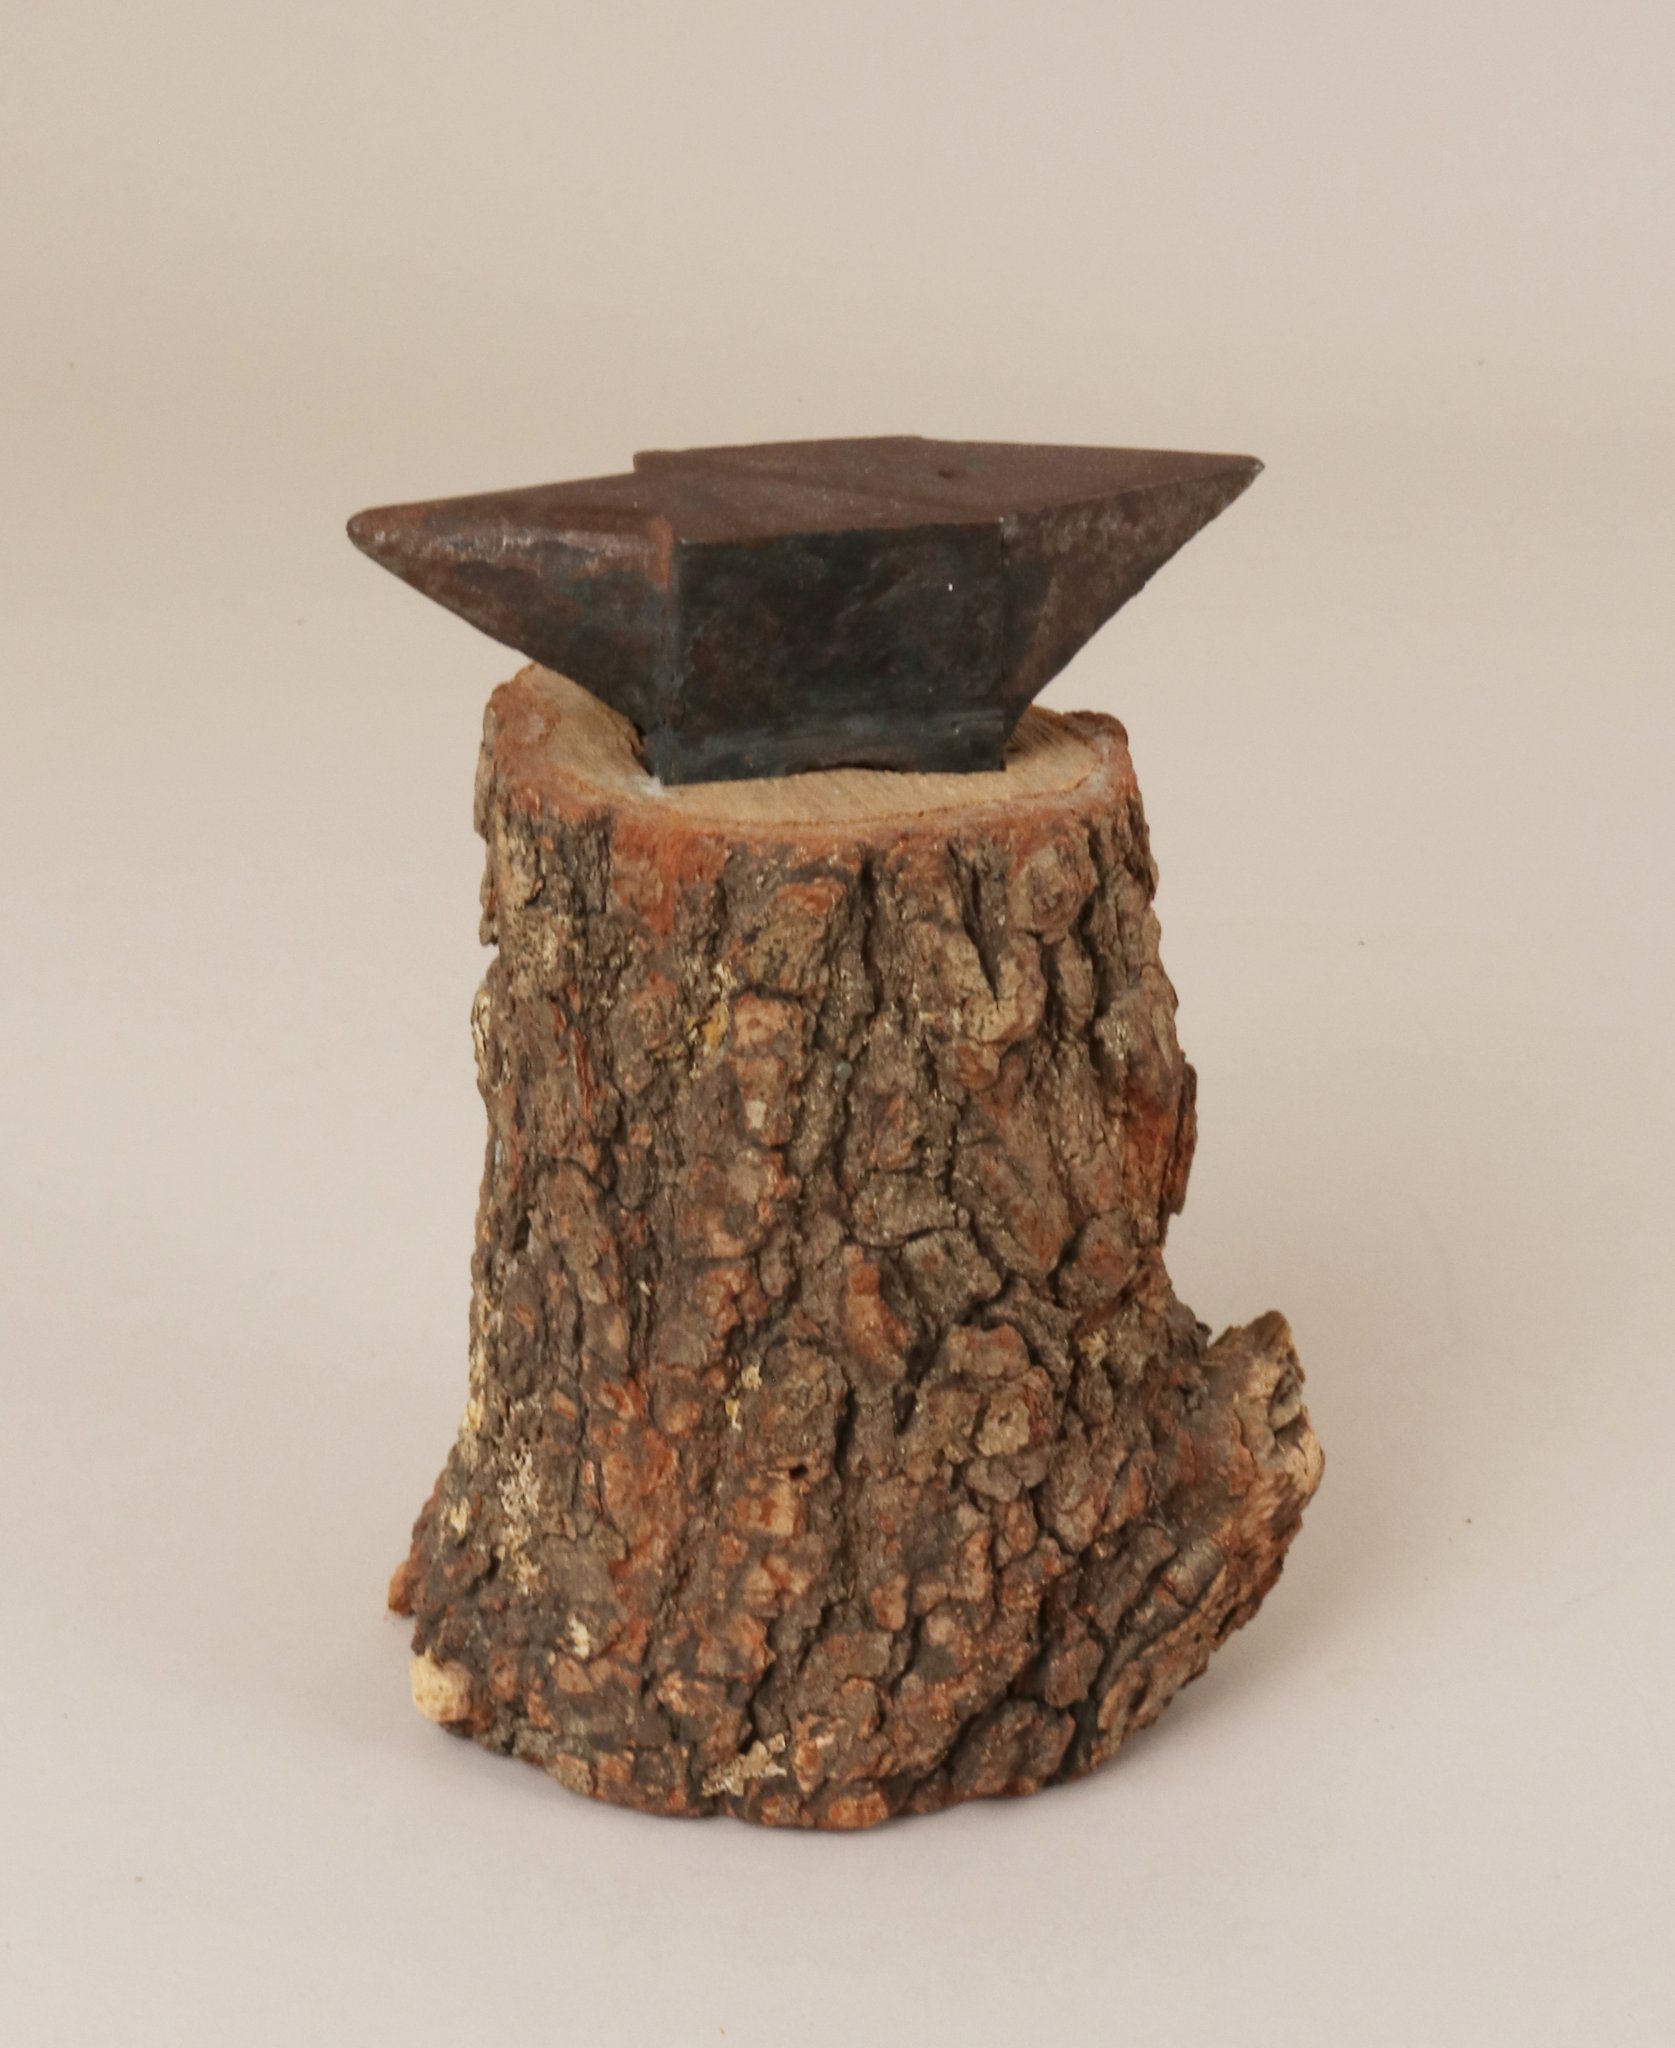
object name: crèche accessory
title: Anvil with stump base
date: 1701-1800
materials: iron